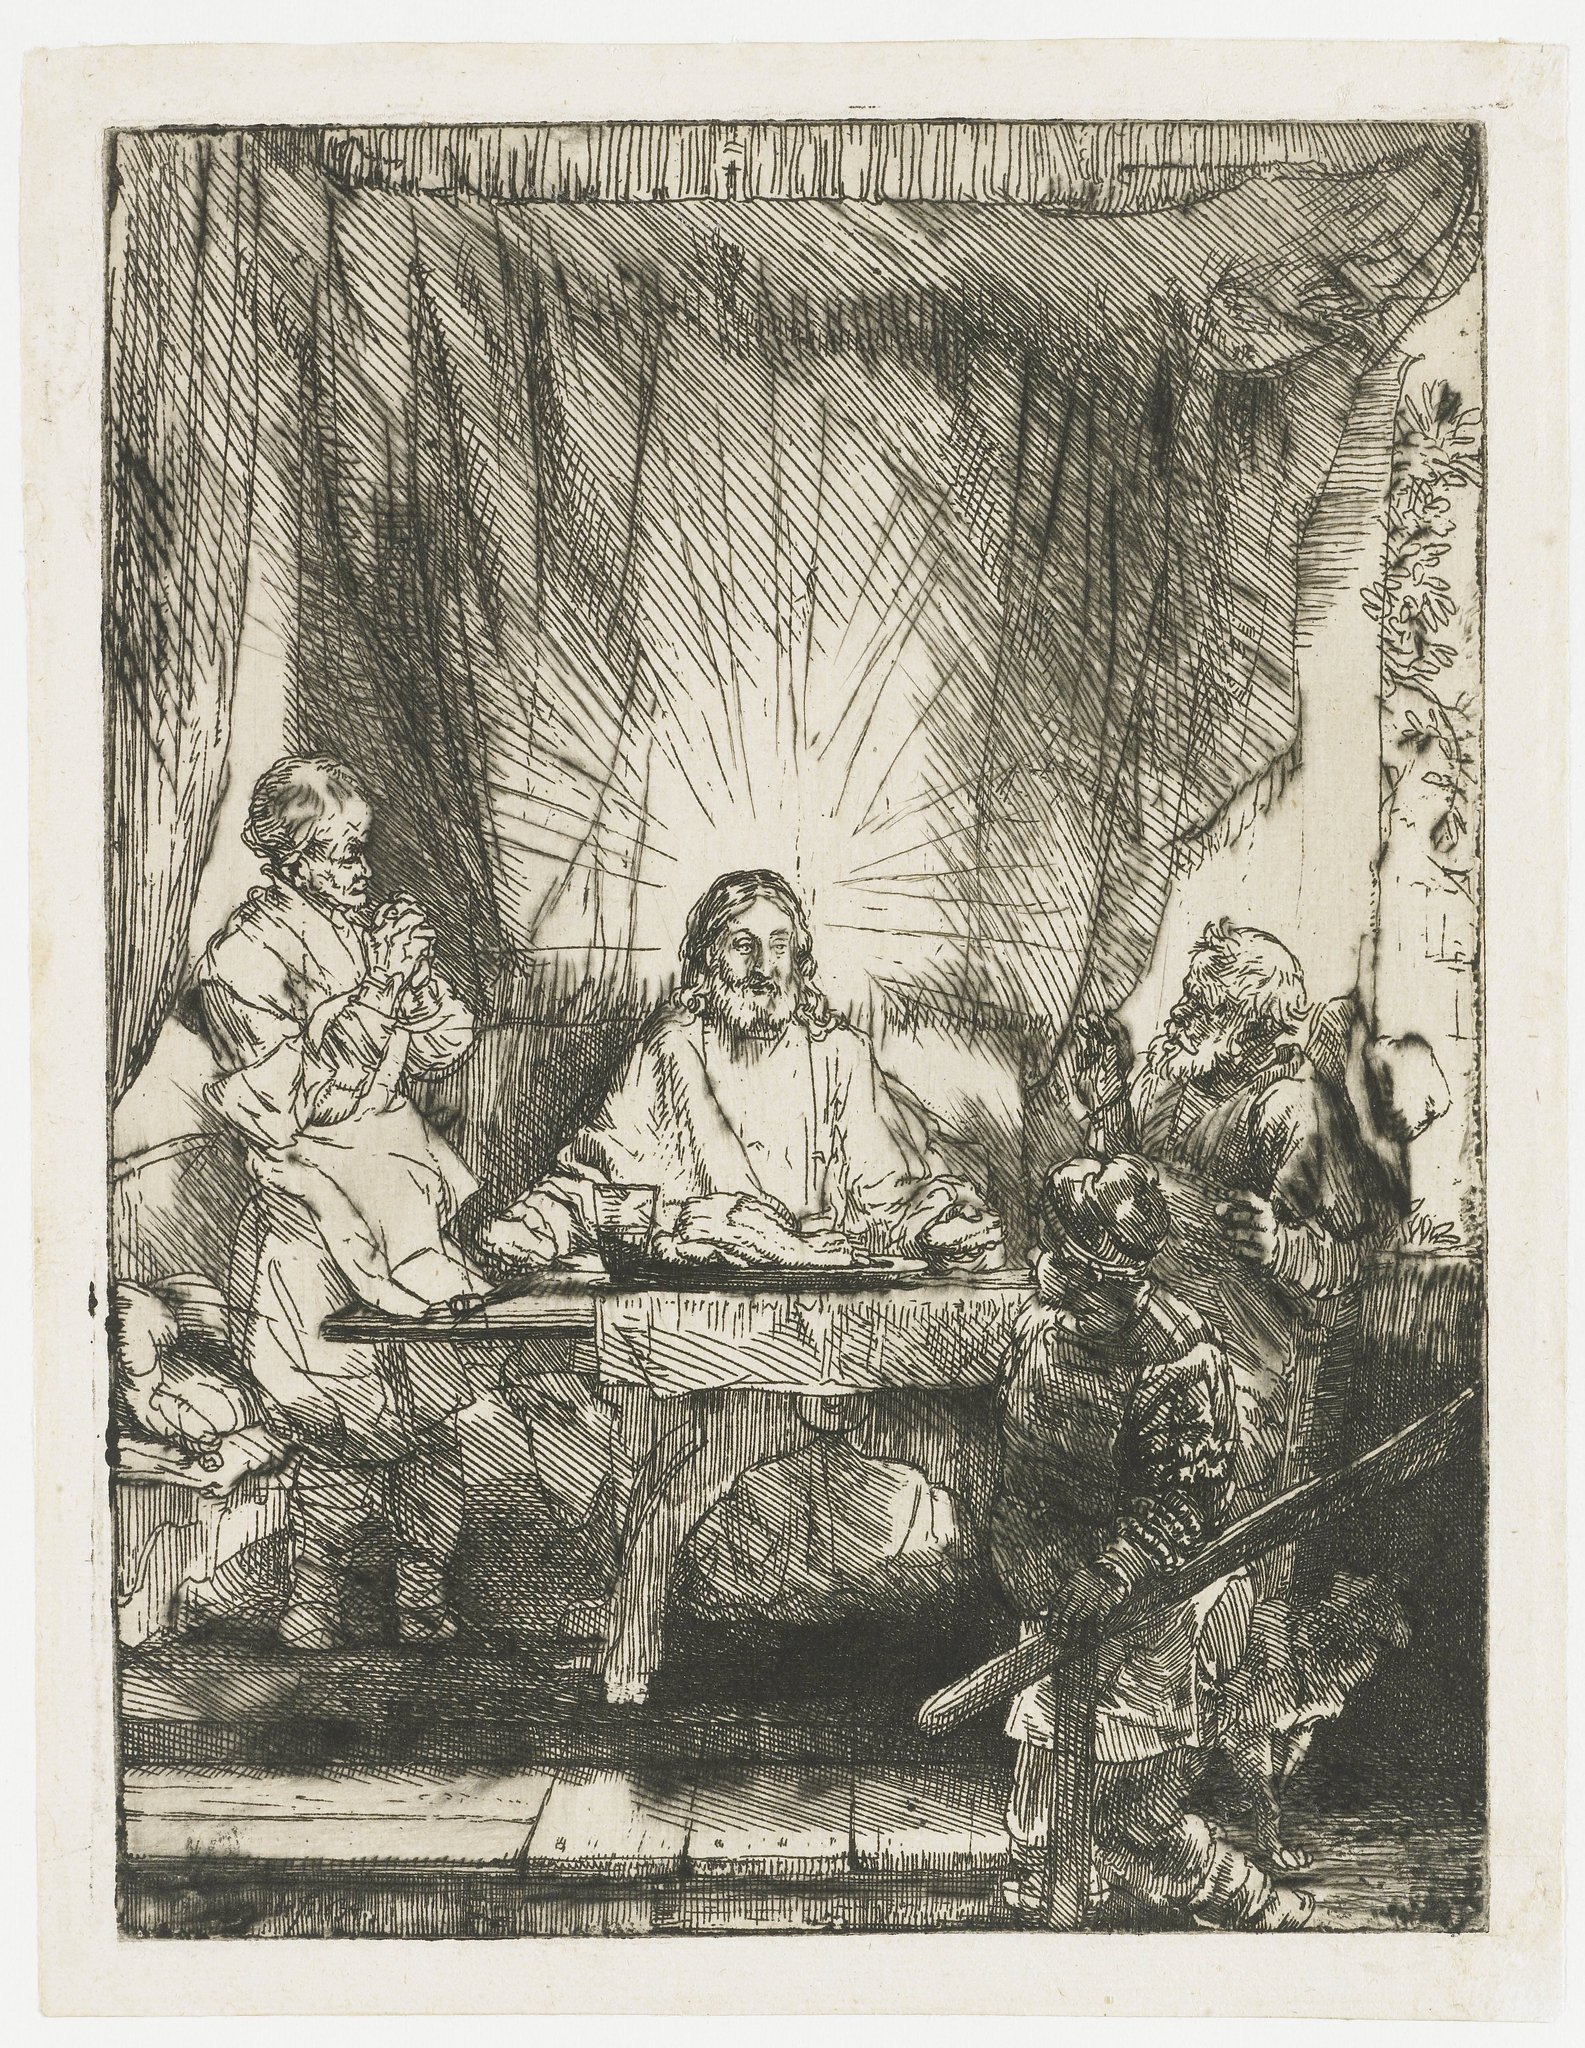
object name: print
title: The Supper at Emmaus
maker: rembrandt van rijn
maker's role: draughtsman, painter, print maker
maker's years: 1606-1669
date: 1654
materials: paper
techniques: drypoint, etching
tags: the supper at emmaus: christ is recognized while blessing or breaking the bread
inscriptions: collector's mark: Lugt 240, signature and date: ‘Rembrandt f. 1654’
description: n this later version, Rembrandt deviates from tradition by depicting the sharing rather than the breaking of the bread. The two disciples react with surprise. The innkeeper calmly descending the stairs seems unaware of what is transpiring. Unlike previously, here Rembrandt places Christ under a baldachin as though he, as the Redeemer, is already seated on a throne.